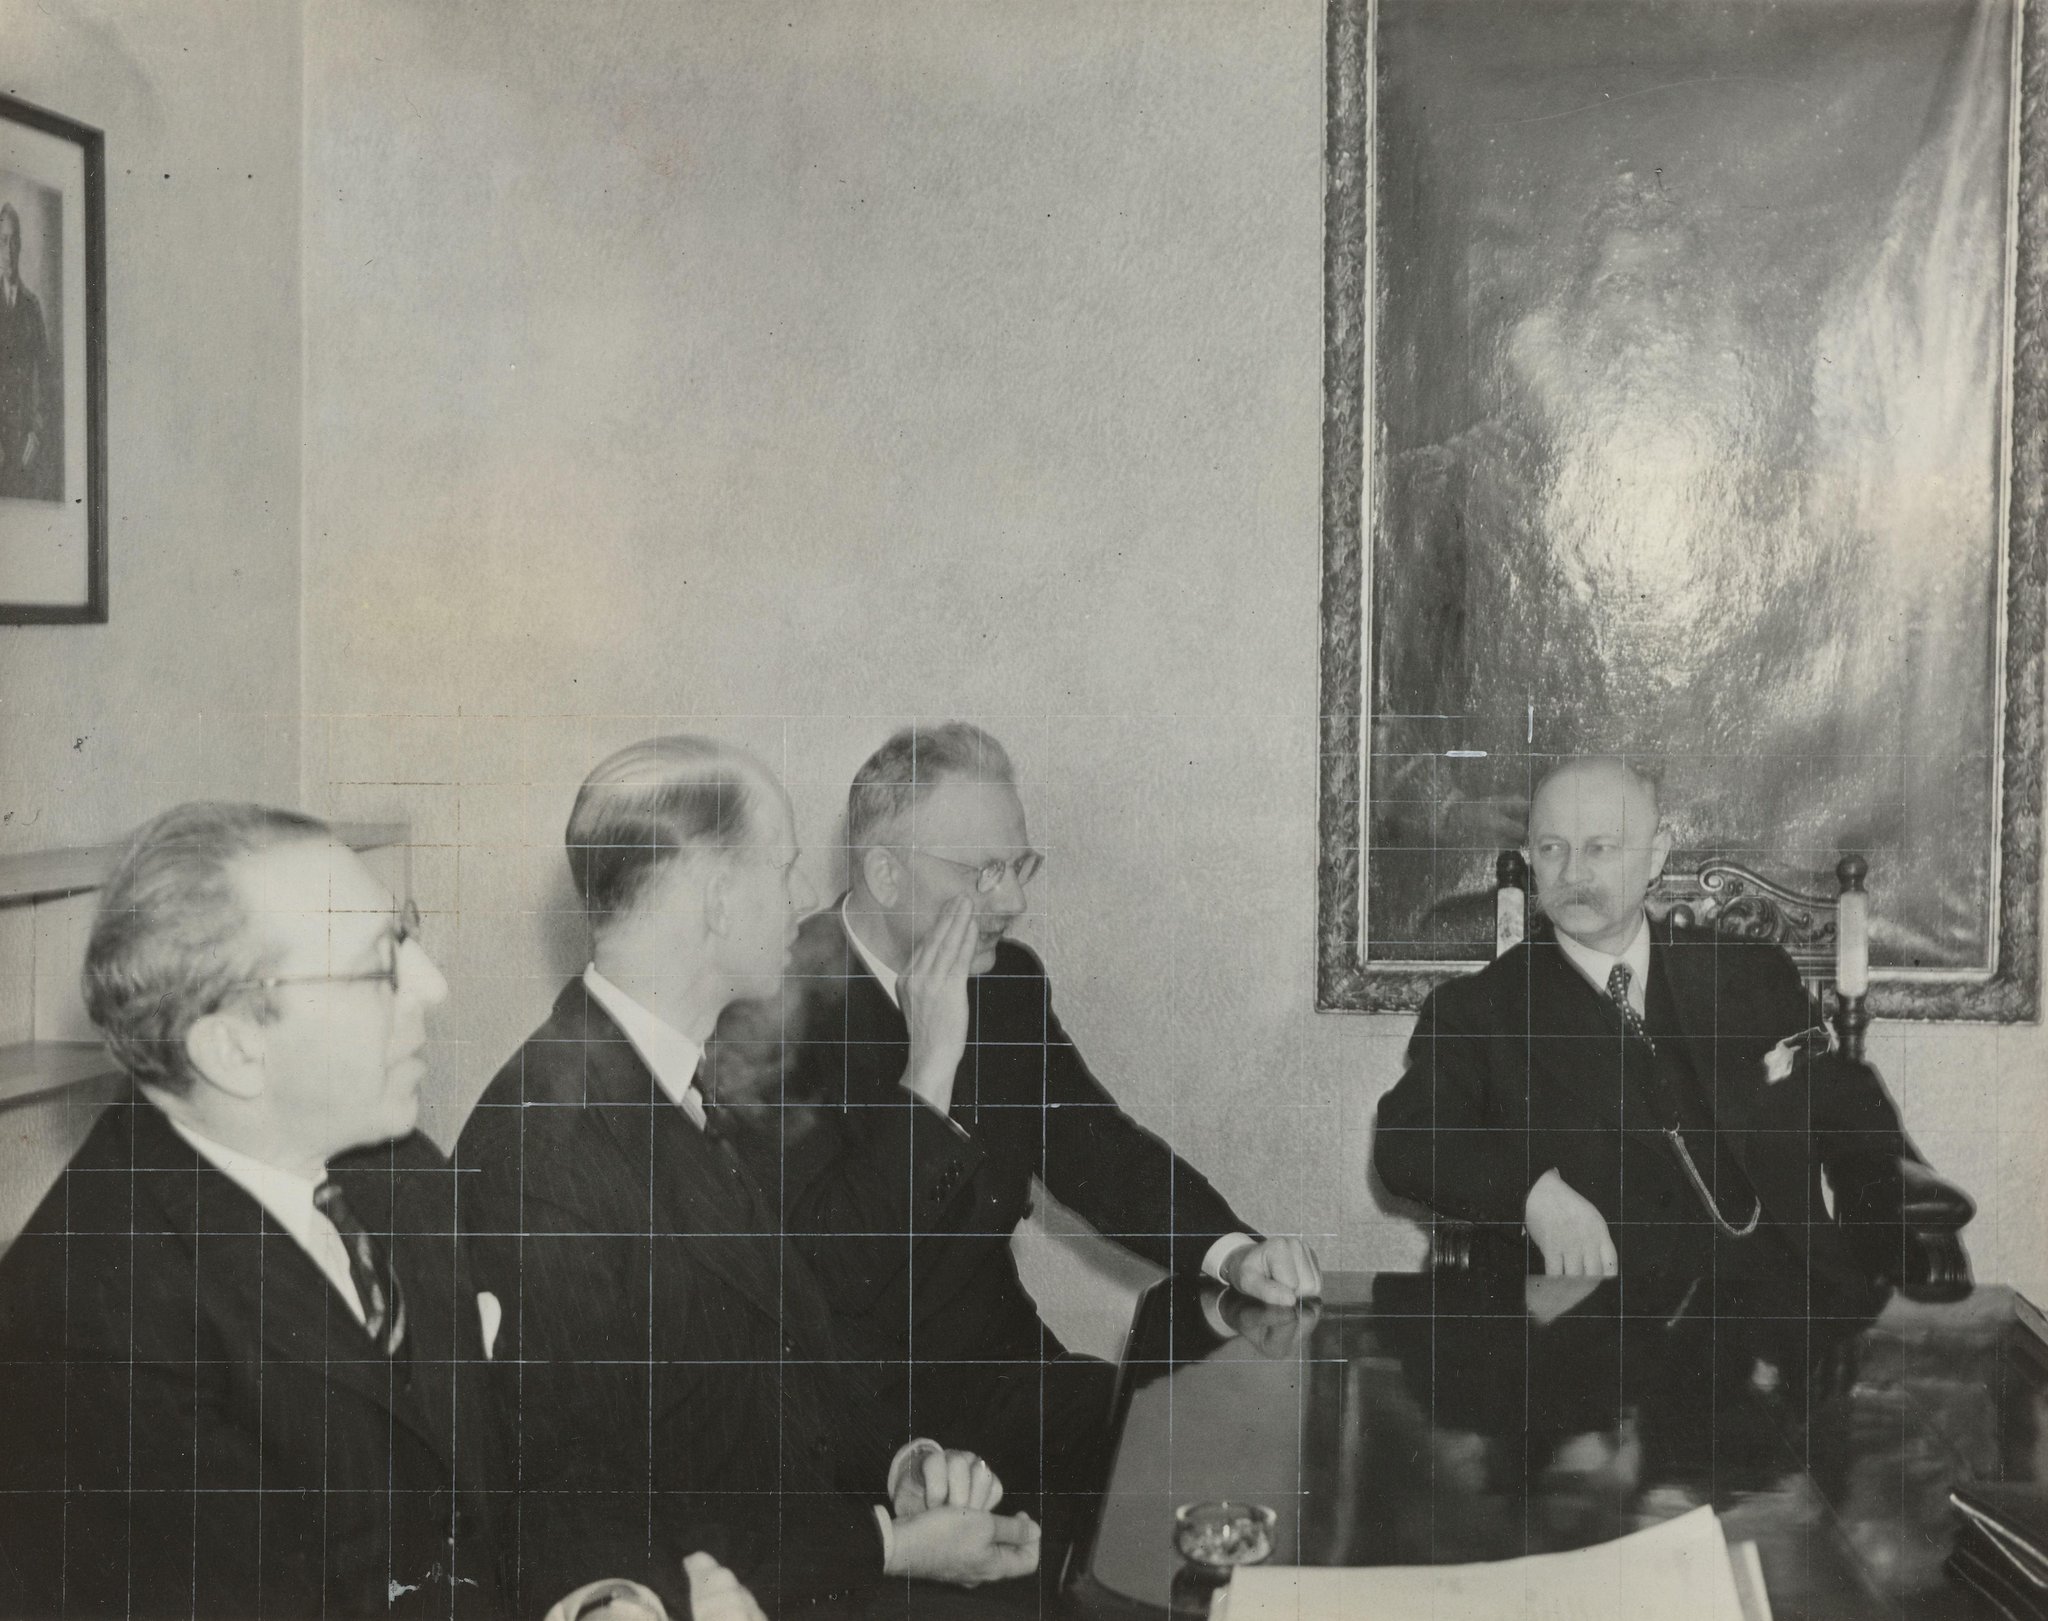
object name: photograph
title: Een groep ministers tijdens de ministerraad in Stratton House in Londen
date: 1941-1944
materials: photographic support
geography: london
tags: politician, utrecht, the hague, pieter sjoerds gerbrandy, london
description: Een groep ministers tijdens de ministerraad in Stratton House in Londen. V.l.n.r.: de minsiters Van Angeren, Van Kleffens, Van den Tempel en Gerbrandy: op de achtergrond het portret van Jan Pietersz. Coen door F. van Hengelaar.Op de muur links een portret van Prins Bernhard. Het lijnennet op de foto is aangebracht door kunstenaar Cor Visser. Deze afbeelding van Van Angeren heeft Cor Visser gebruikt voor het groepsportret van het tweede kabinet Gerbrandy.